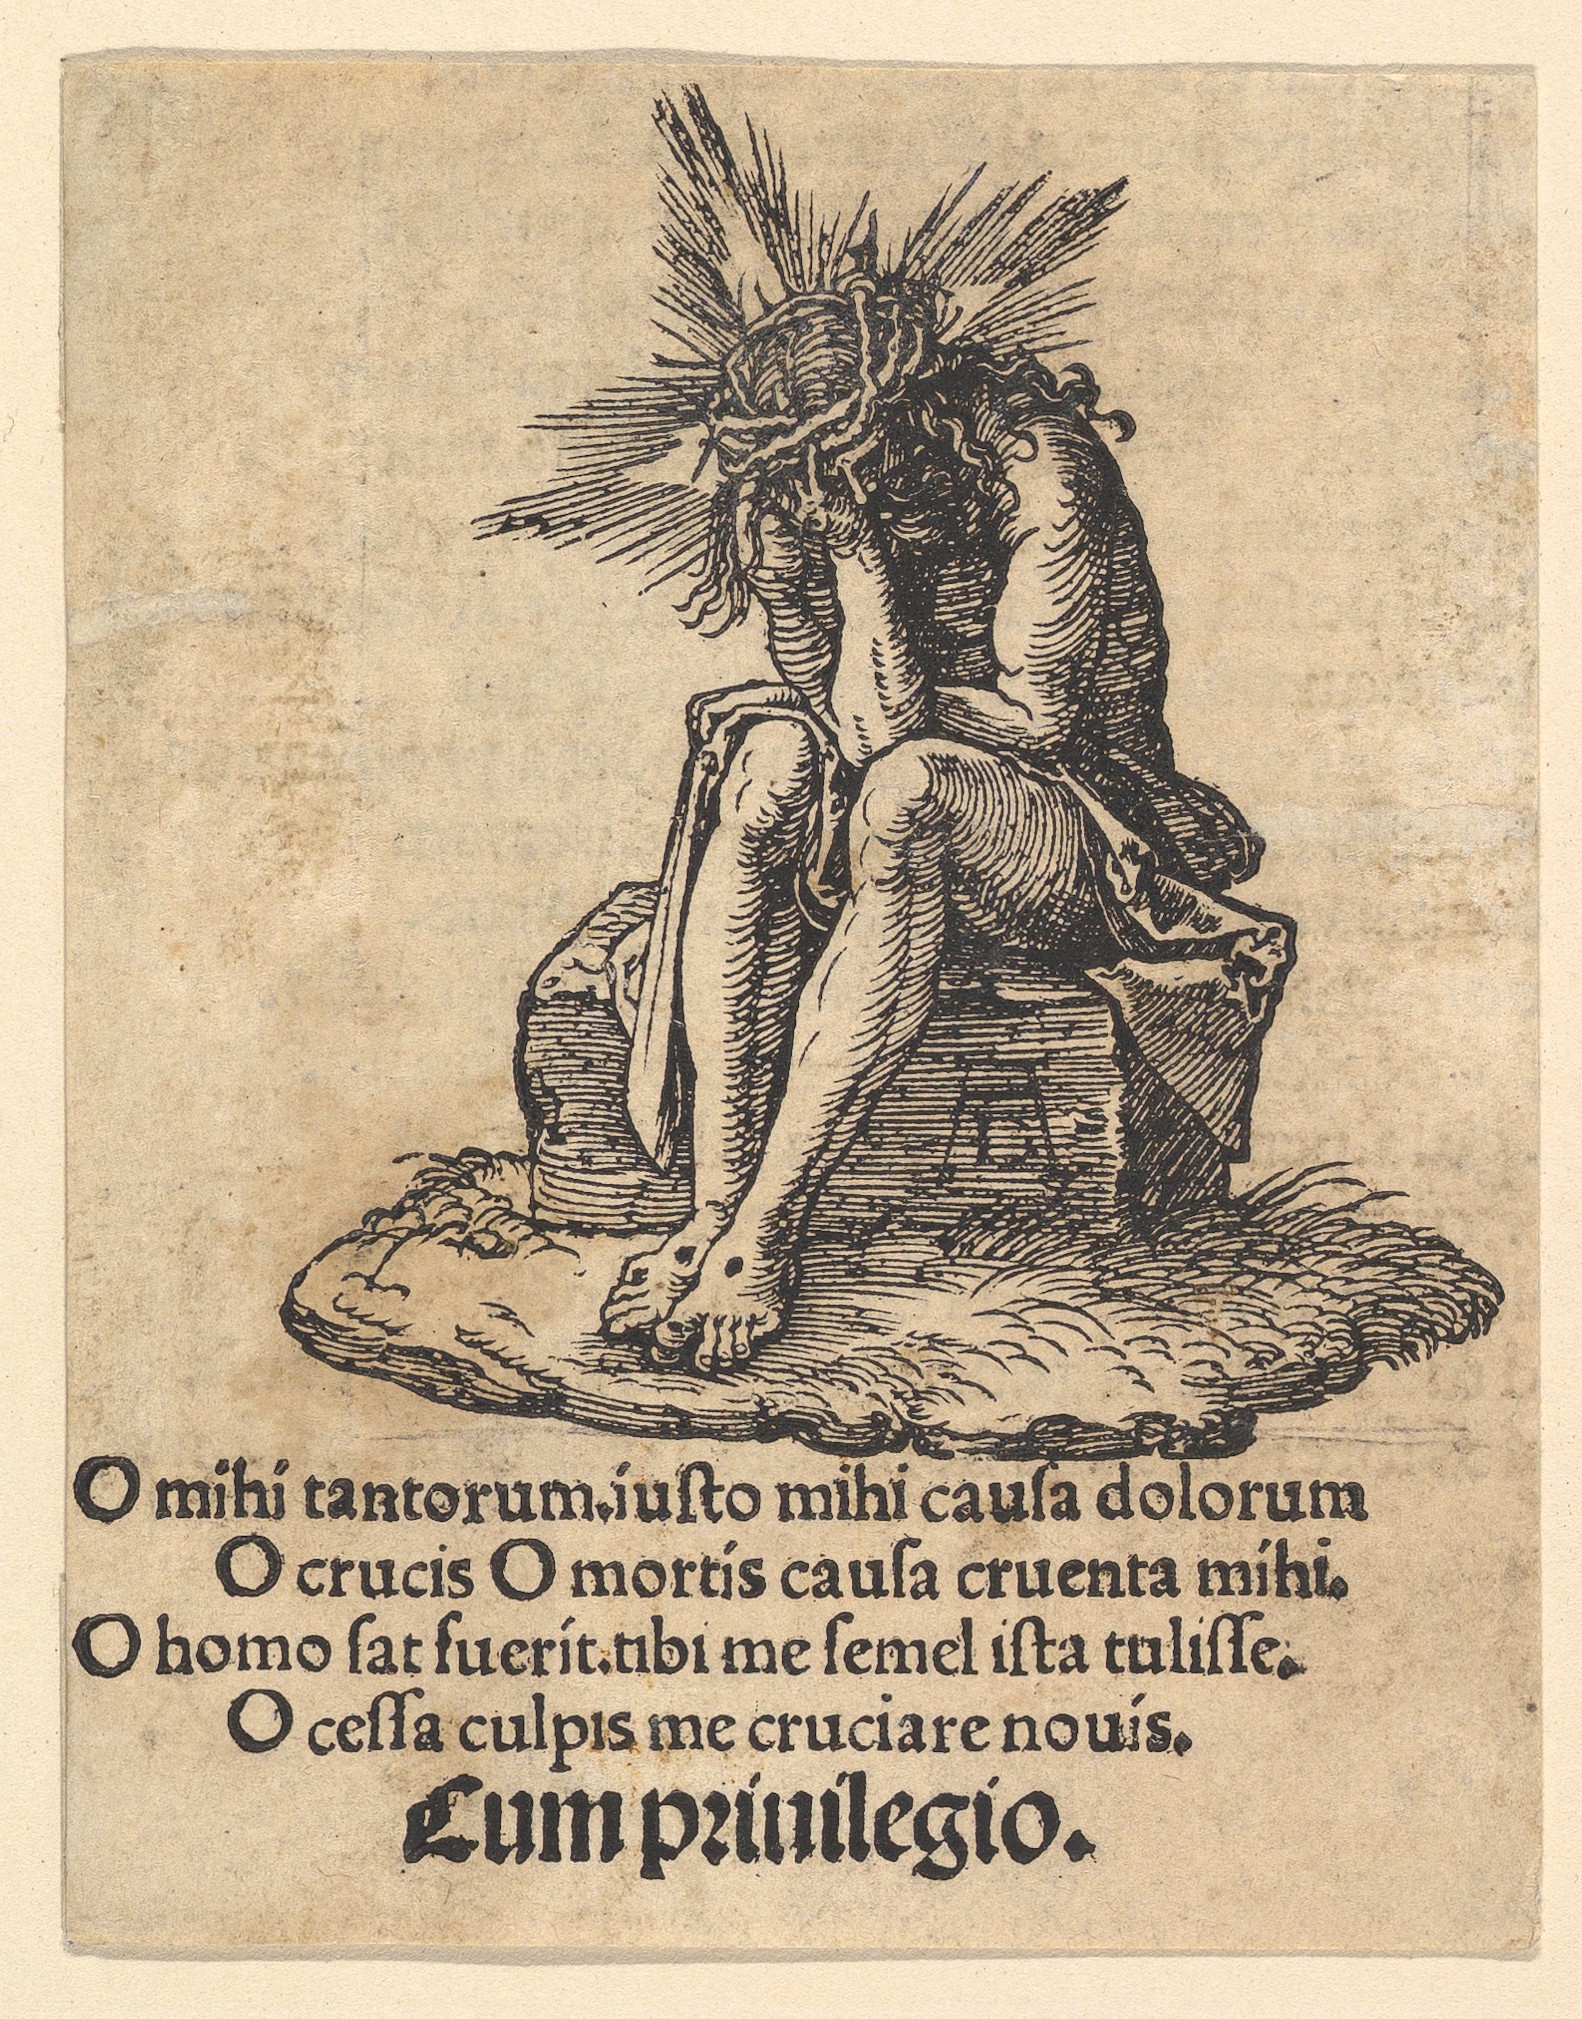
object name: print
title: The Man of Sorrows Seated, title page of "The Small Passion"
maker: albrecht dürer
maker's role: artist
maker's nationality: german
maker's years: 1471-1528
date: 1511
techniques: woodcut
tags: sadness,christ